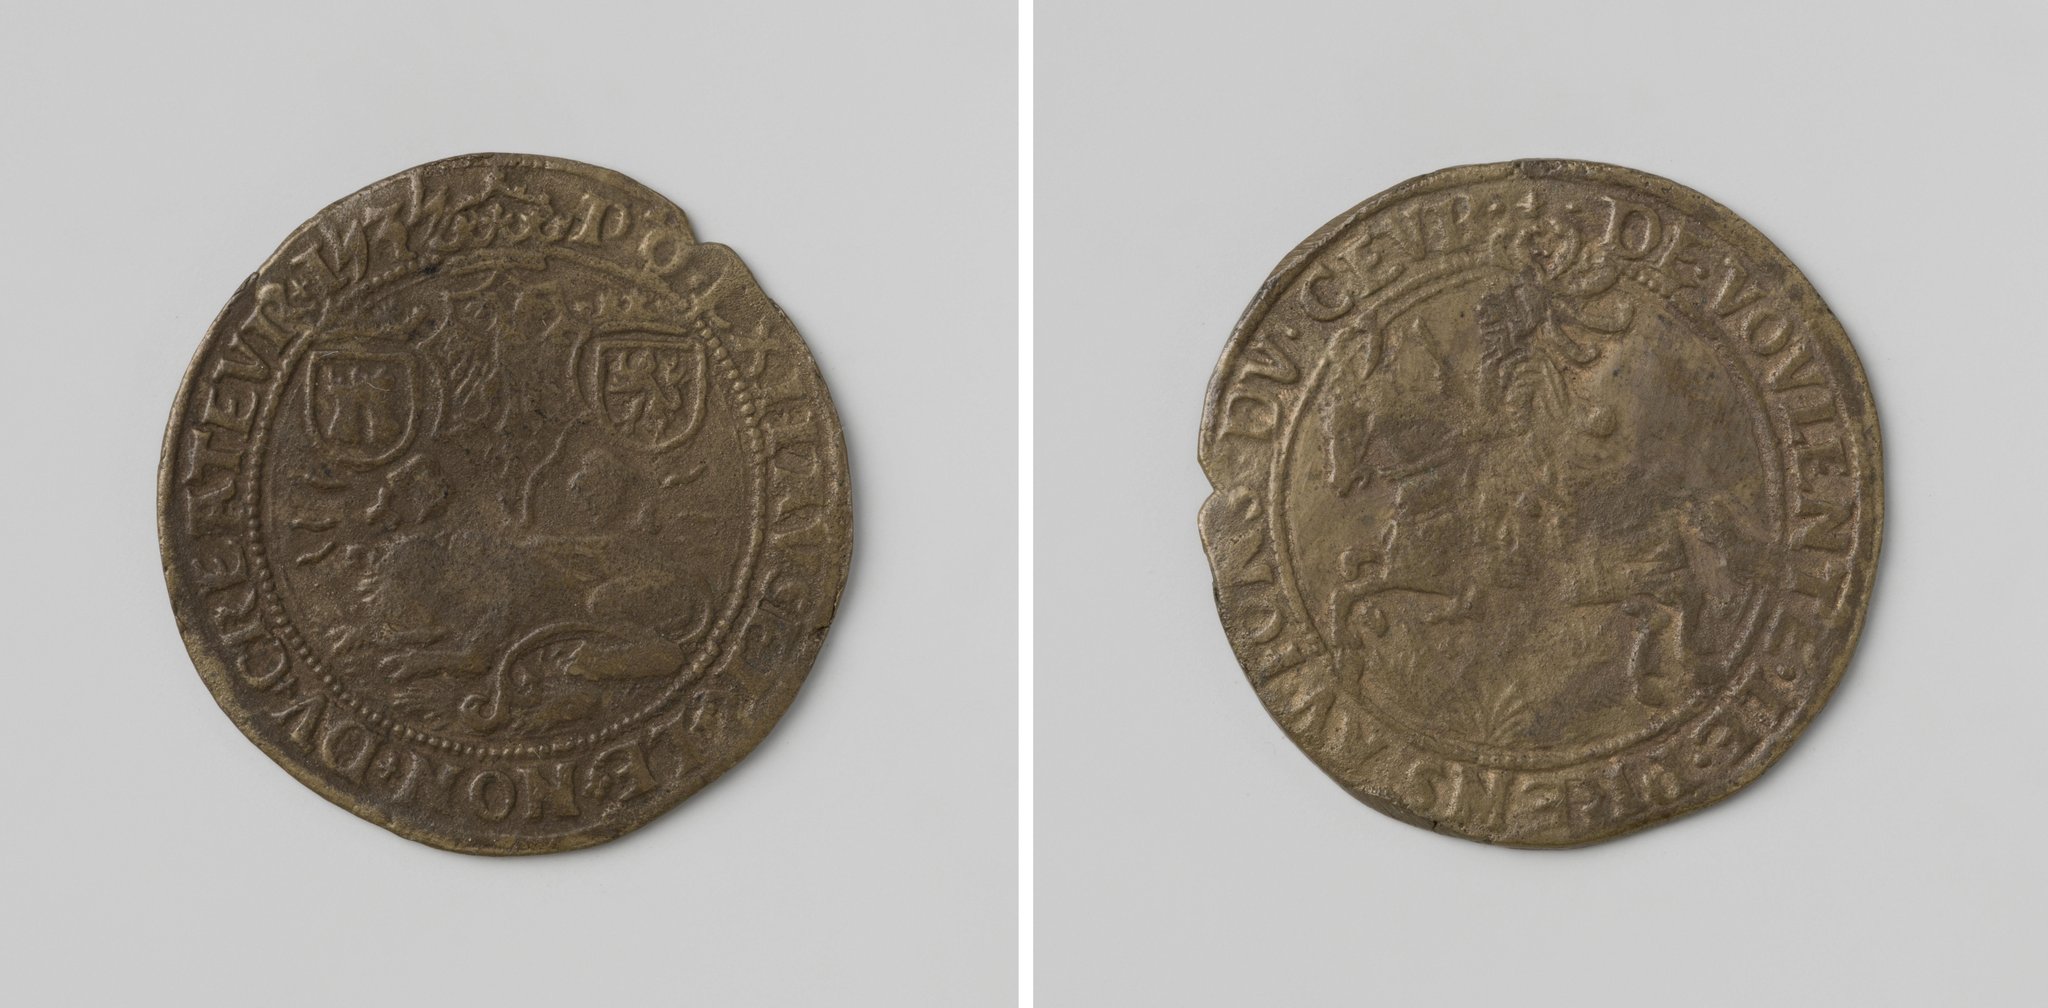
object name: jeton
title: Tunis op de Turken veroverd, rekenpenning ter ere van Karel V, Duits keizer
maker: Anonymous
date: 1535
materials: copper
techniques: striking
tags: ghent, charles v (holy roman emperor and king of spain)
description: Koperen penning. Voorzijde: drie gekroonde wapenschilden boven twee vuurslagen, waar vonken uitschieten en liggende leeuw binnen omschrift. Keerzijde: Karel V in harnas te paard met commandostaf in rechterhand binnen omschrift